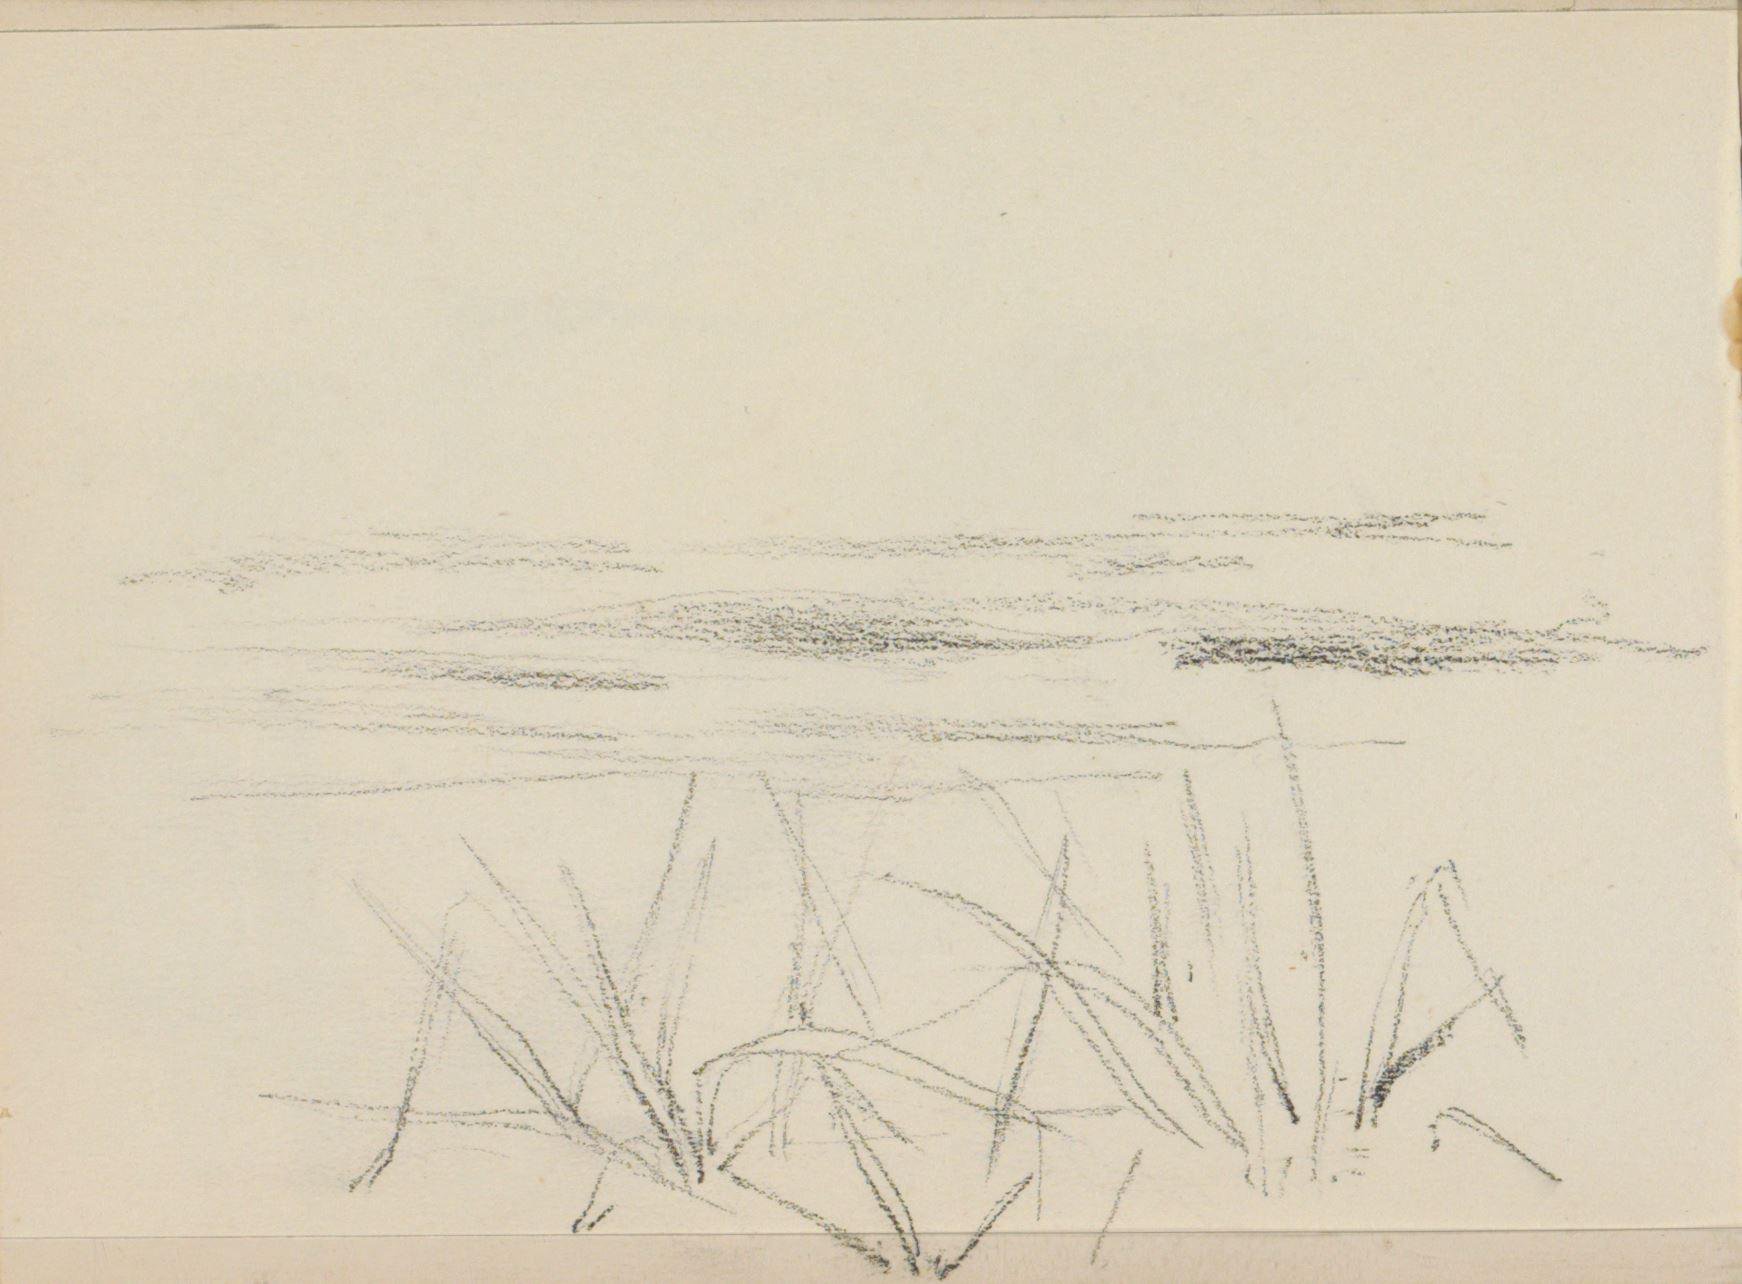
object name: sketchbook leaf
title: Waterplanten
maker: a.a.l. de grammont-hubrecht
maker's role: draughtsman, painter, print maker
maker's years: 1855-1913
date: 1865-1913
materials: chalk, paper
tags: plants (in general)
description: Blad 28 verso uit een schetsboek met 38 bladen.